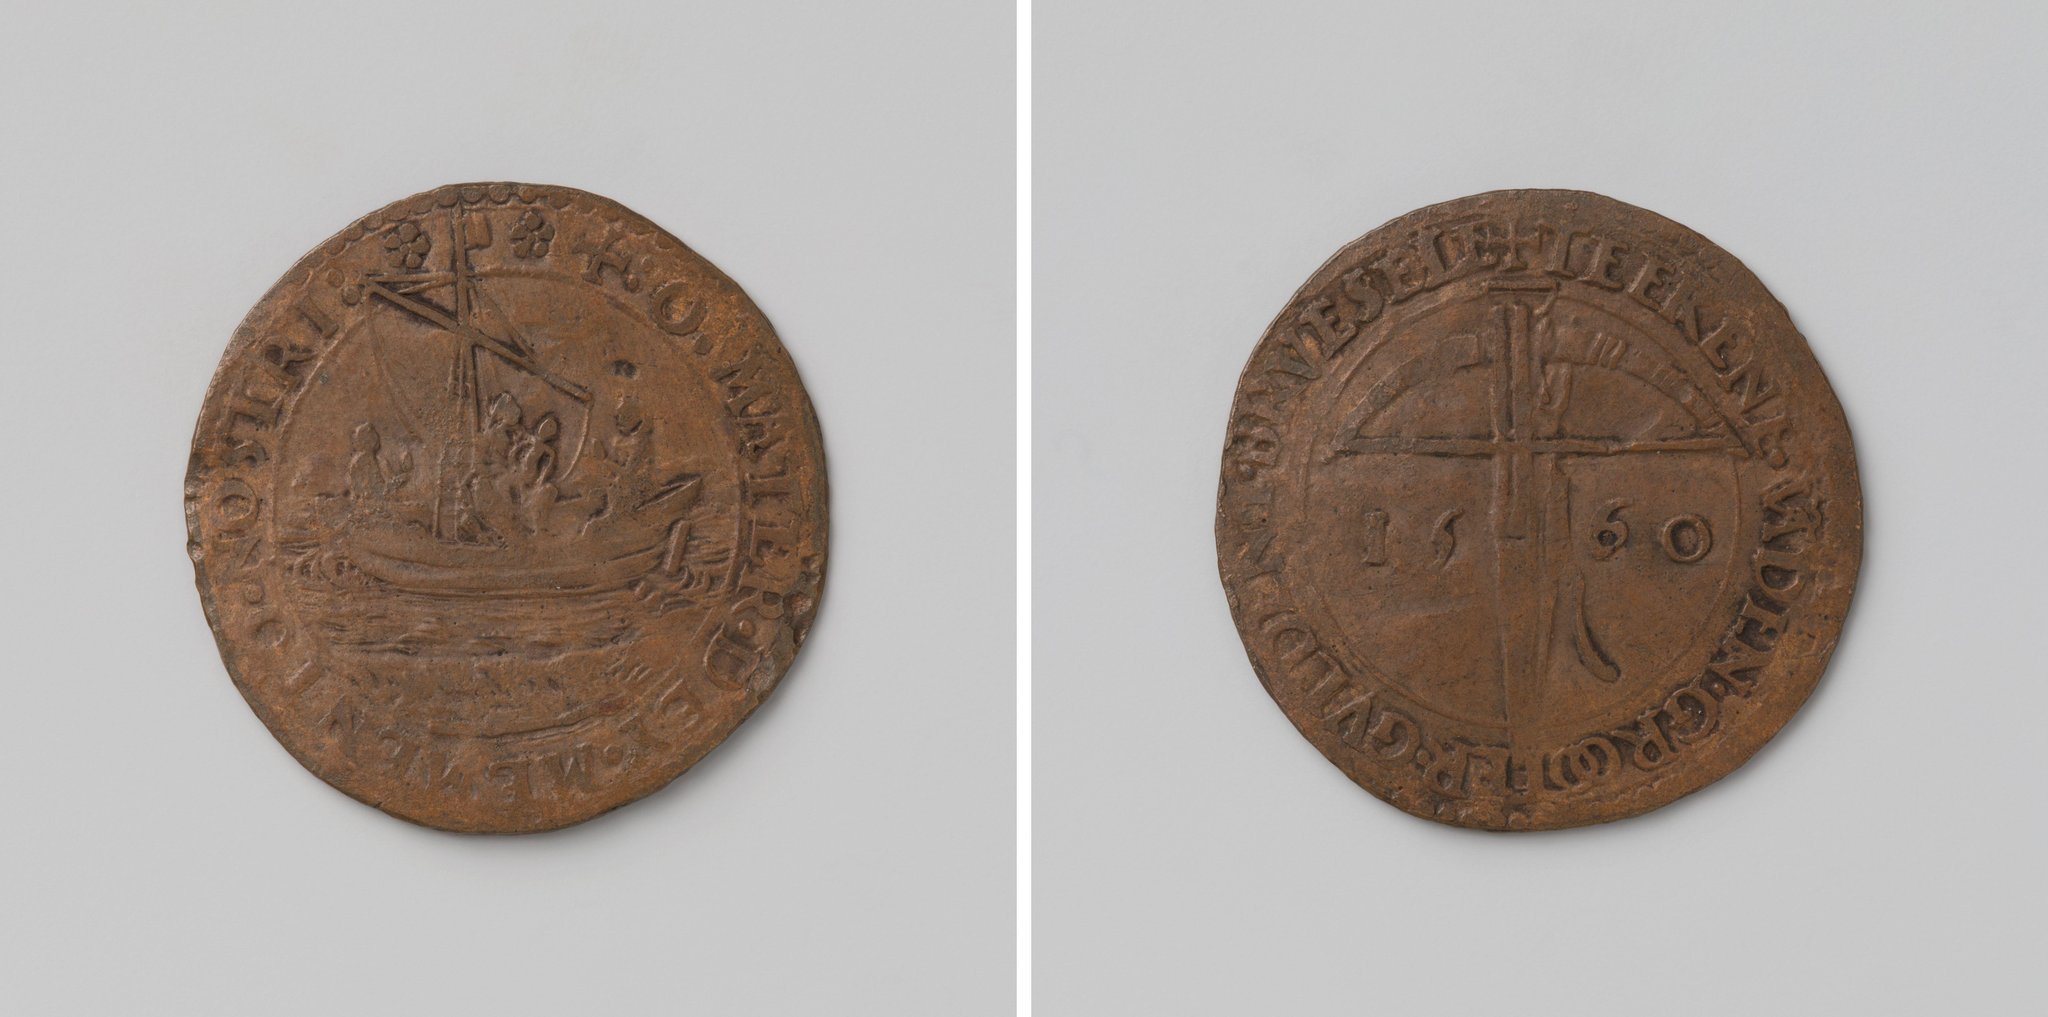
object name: marksman medal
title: Voetboogschutterij of Grote Gulde van Brussel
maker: Anonymous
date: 1560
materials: copper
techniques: striking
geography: brussels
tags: brussels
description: Koperen penning. Voorzijde: zeilbootje met maagd Maria, die Christuskind op arm draagt, zittend temidden van twee biddende personen binnen omschrift. Keerzijde: voetboog tussen jaartal binnen omschrift